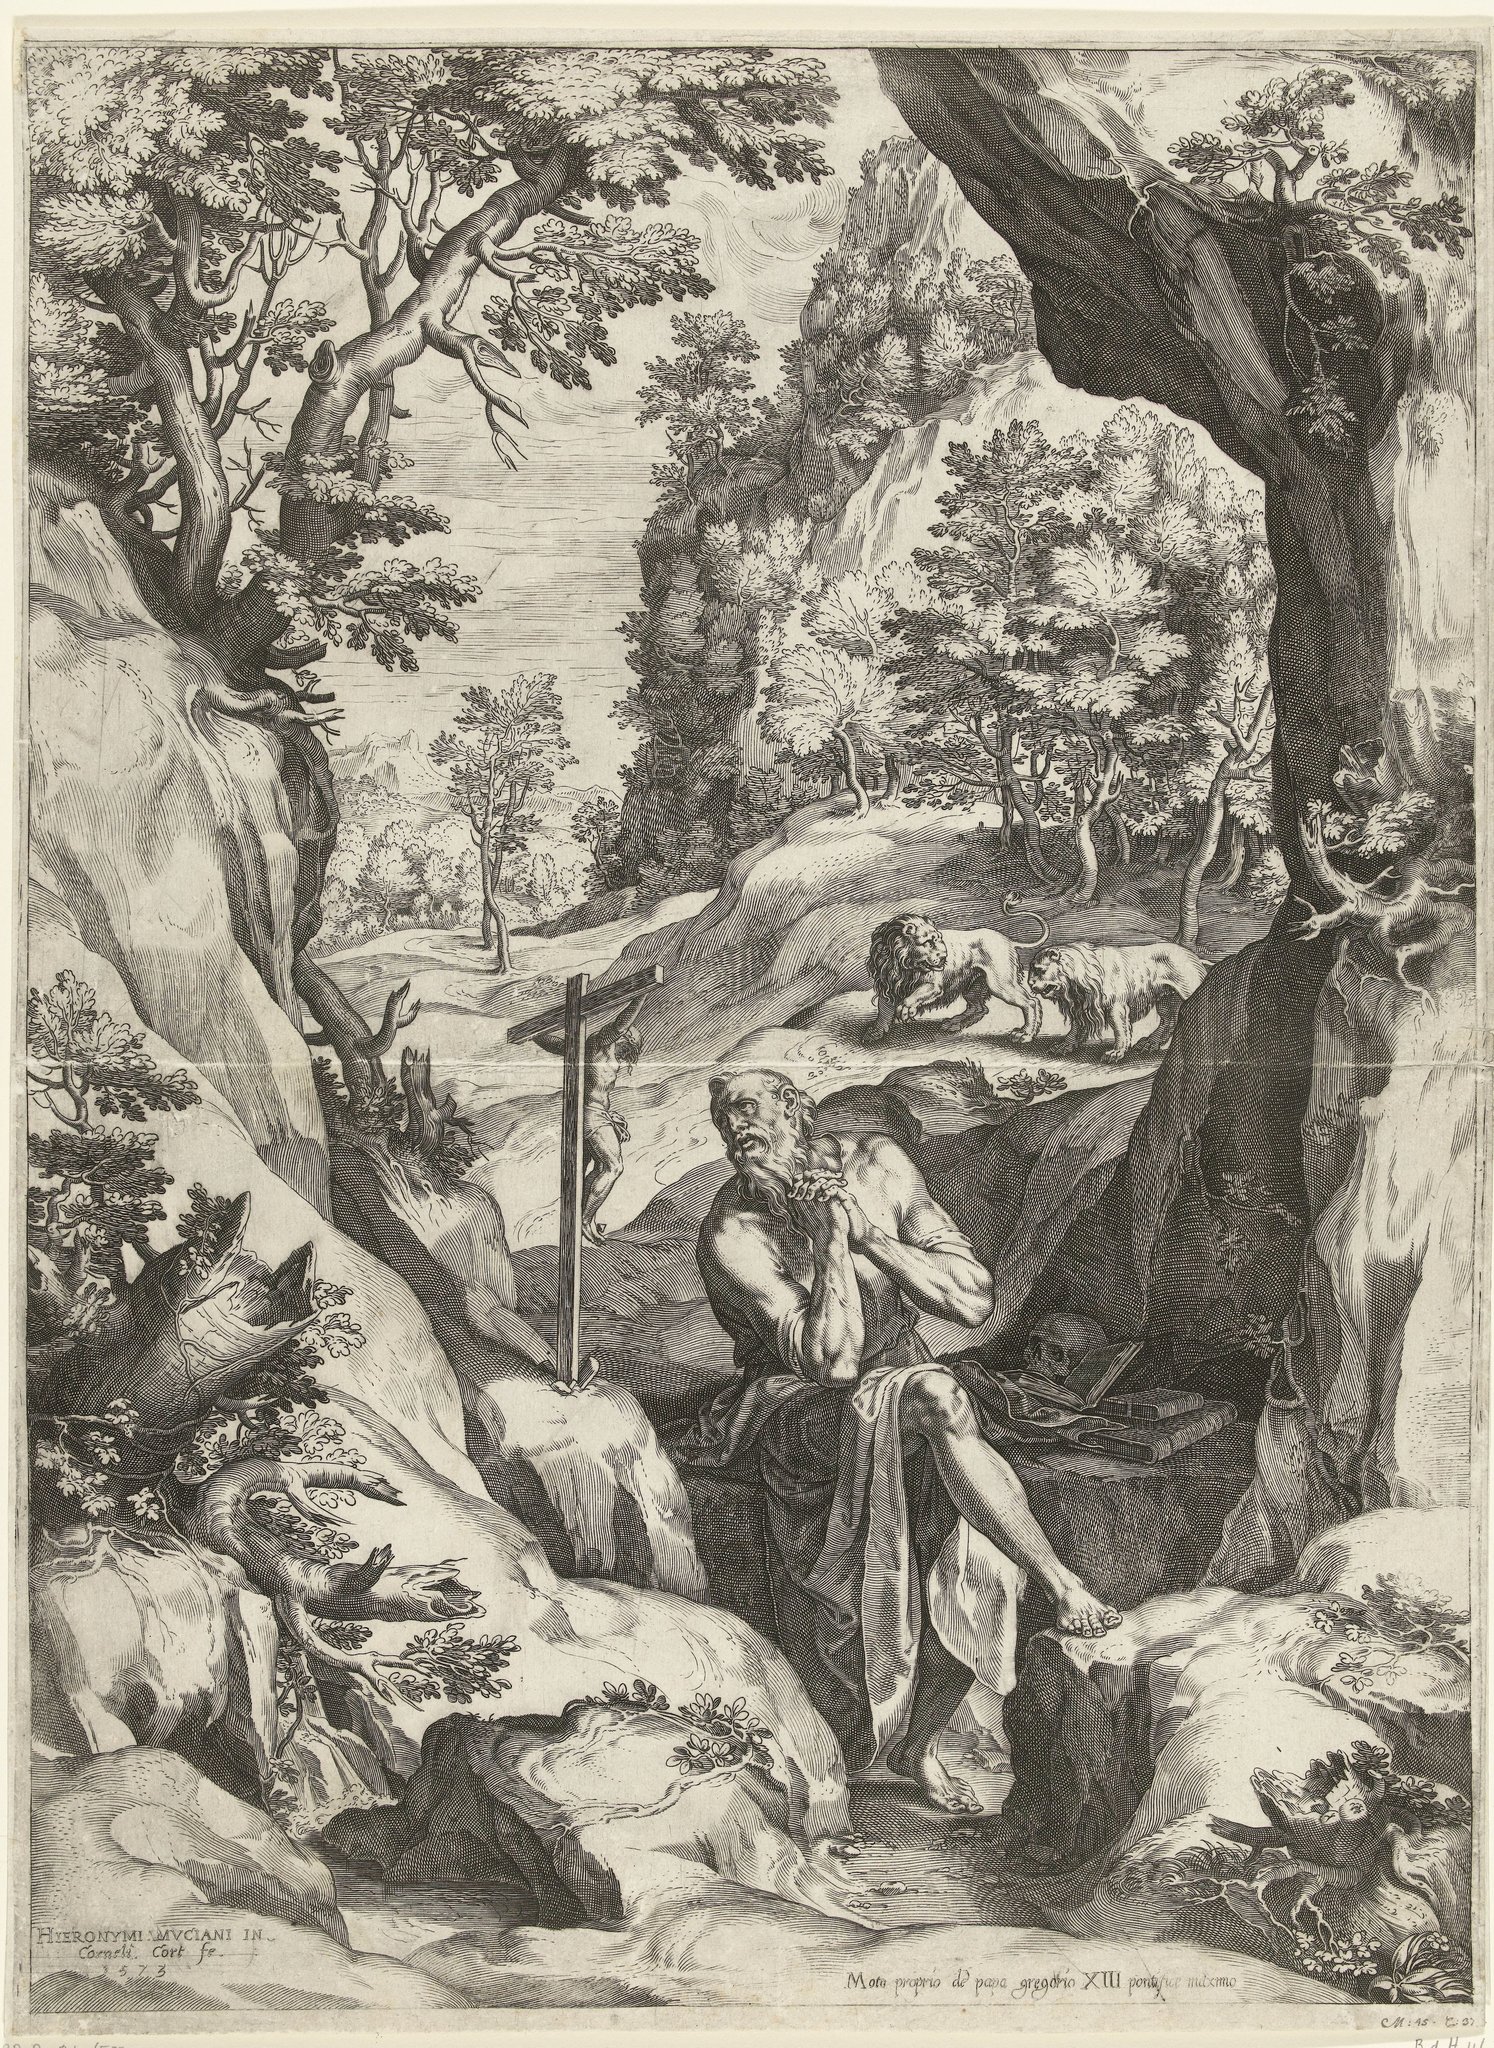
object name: print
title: Landschap met de H. Hieronymus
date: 1573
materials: paper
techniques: engraving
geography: rome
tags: martyrdom, suffering, misfortune, death of st. jerome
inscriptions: collector's mark: Lugt 240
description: Hieronymus, biddend voor een crucifix in een landschap, naast hem boeken en een doodskop. Op de achtergrond twee leeuwen.